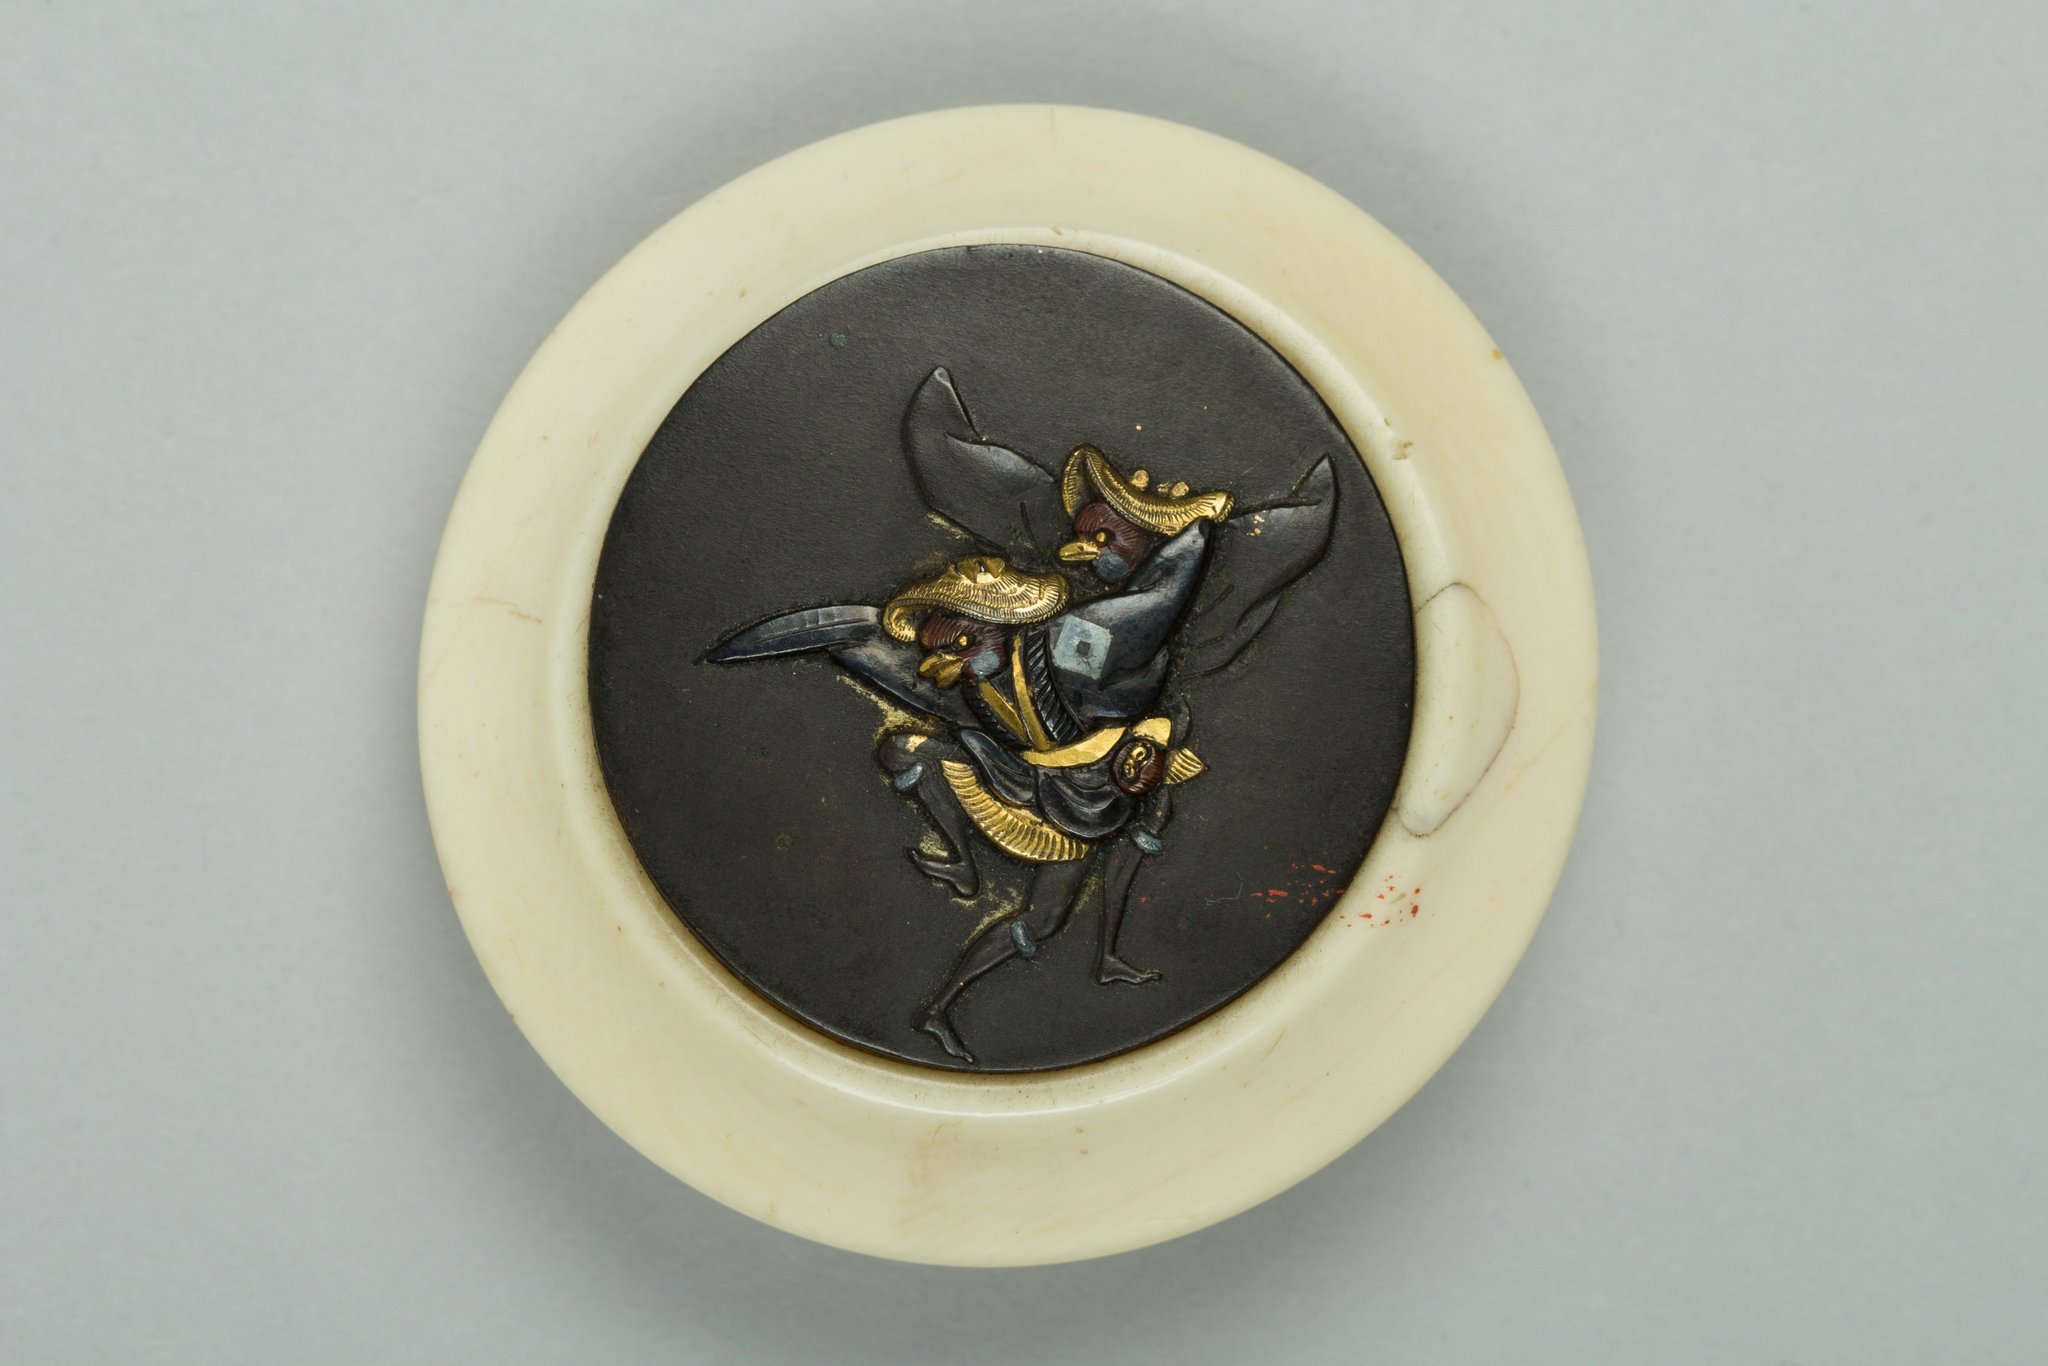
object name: netsuke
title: Netsuke of Two Tengu Dancing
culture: japanese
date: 1801-1900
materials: ivory, metal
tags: birds,dancing